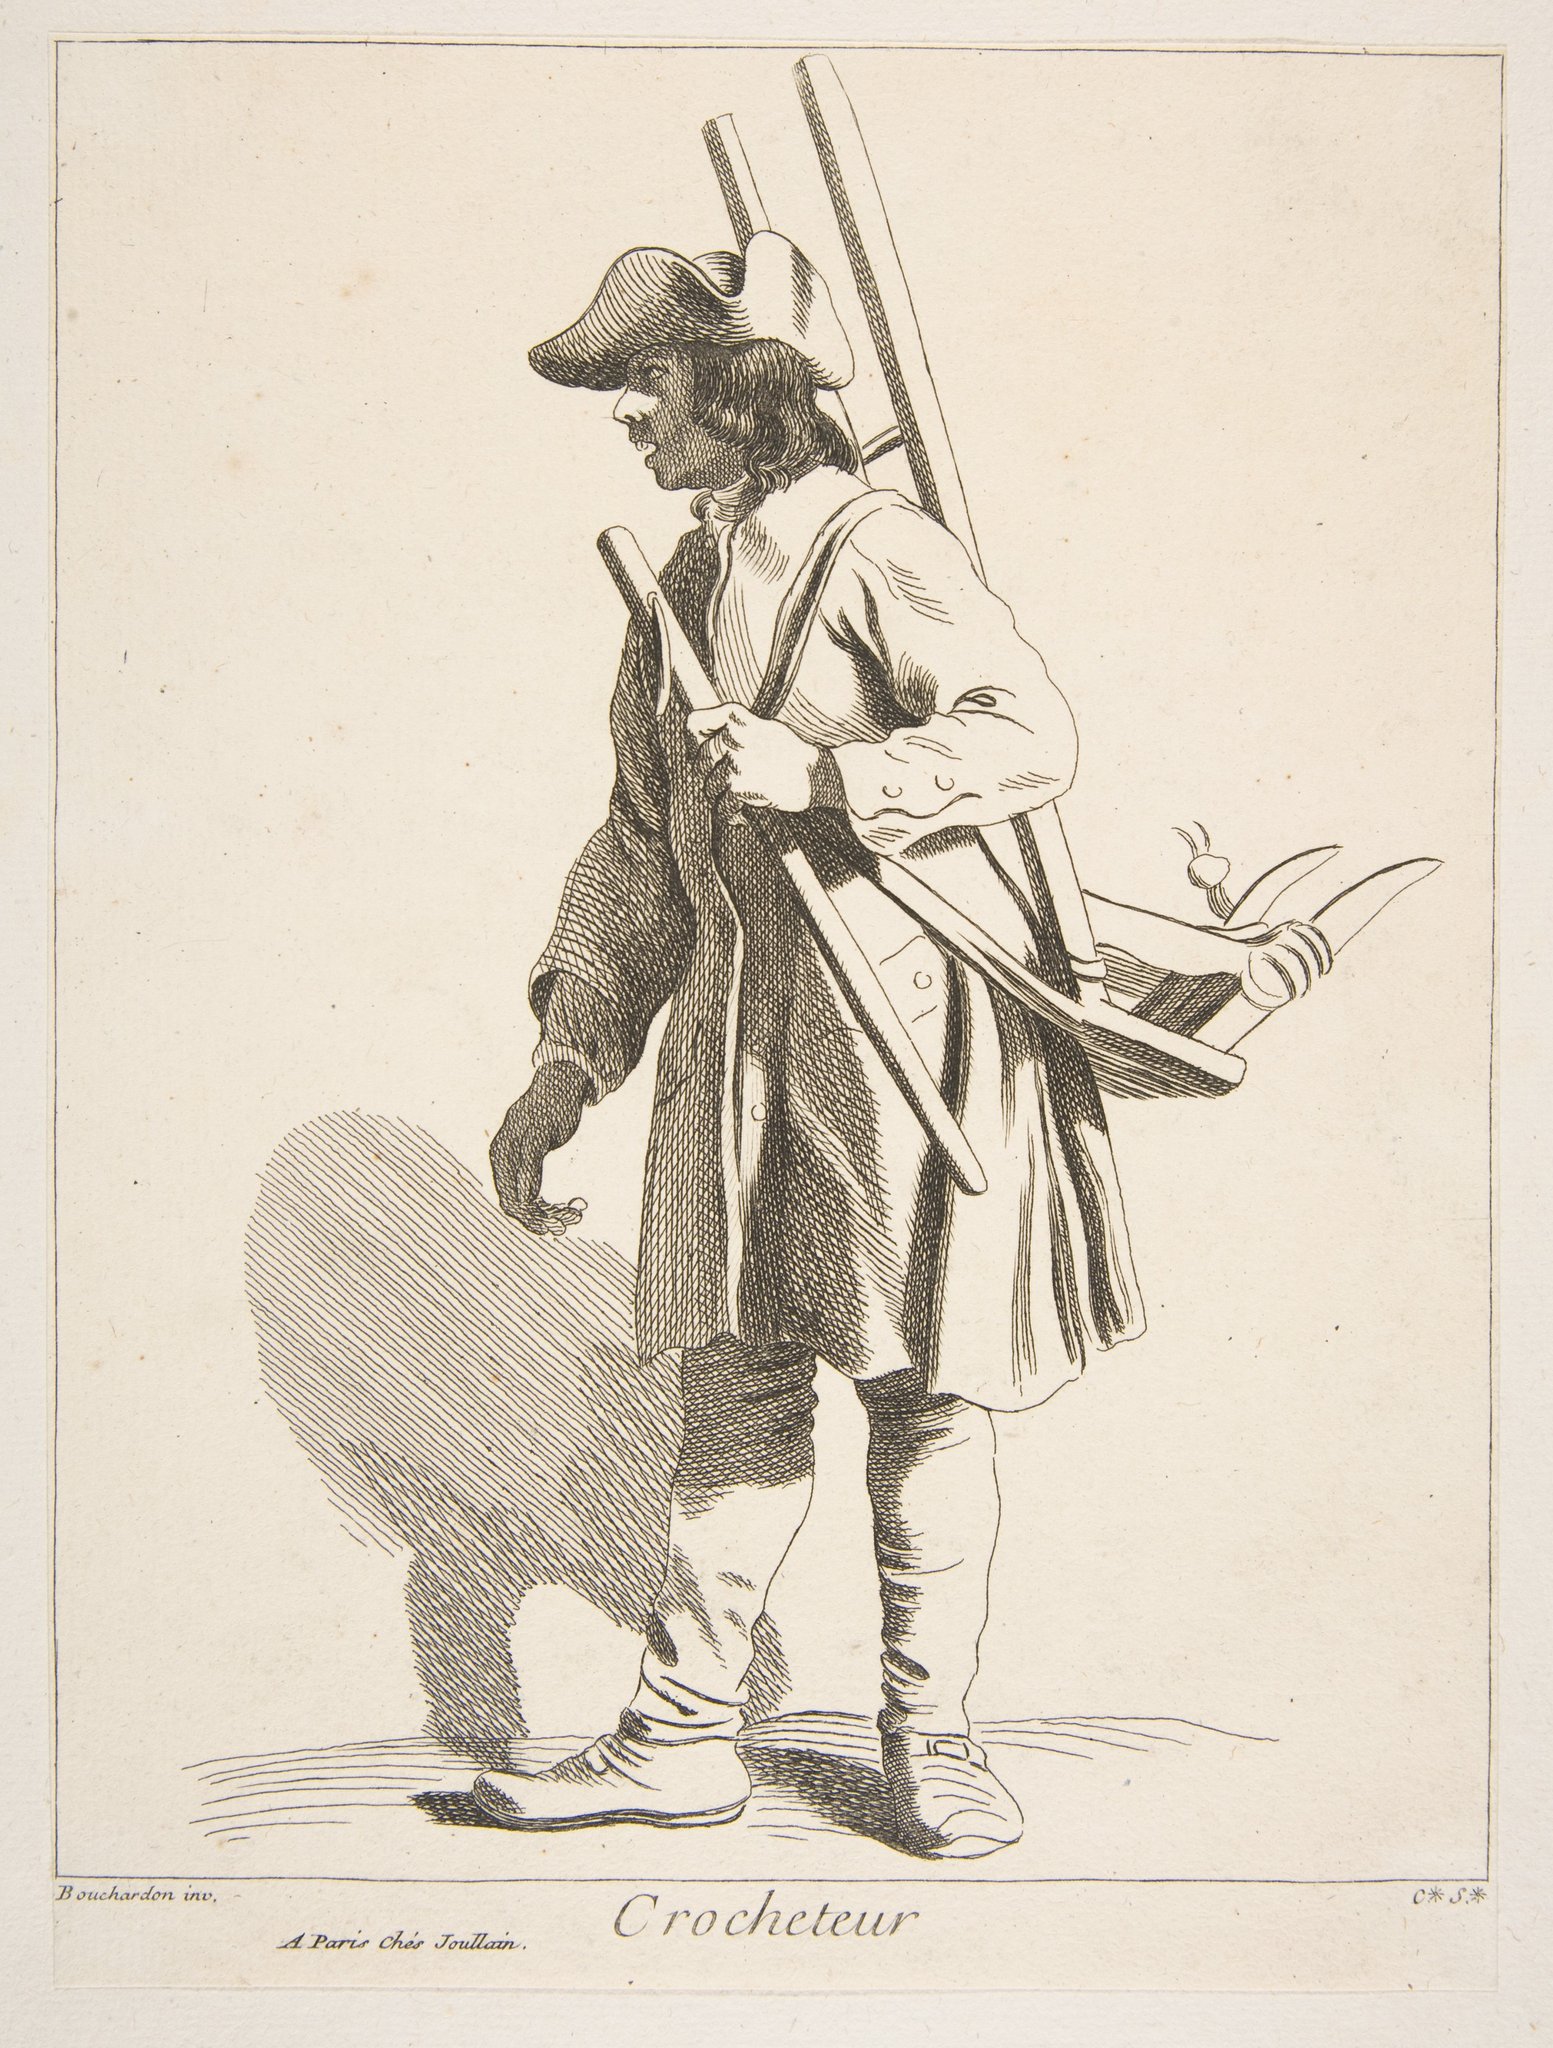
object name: print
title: Hardware Peddler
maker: anne claude philippe de tubières, comte de caylus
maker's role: artist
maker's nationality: french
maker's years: 1692-1765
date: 1746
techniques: engraving, etching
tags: men